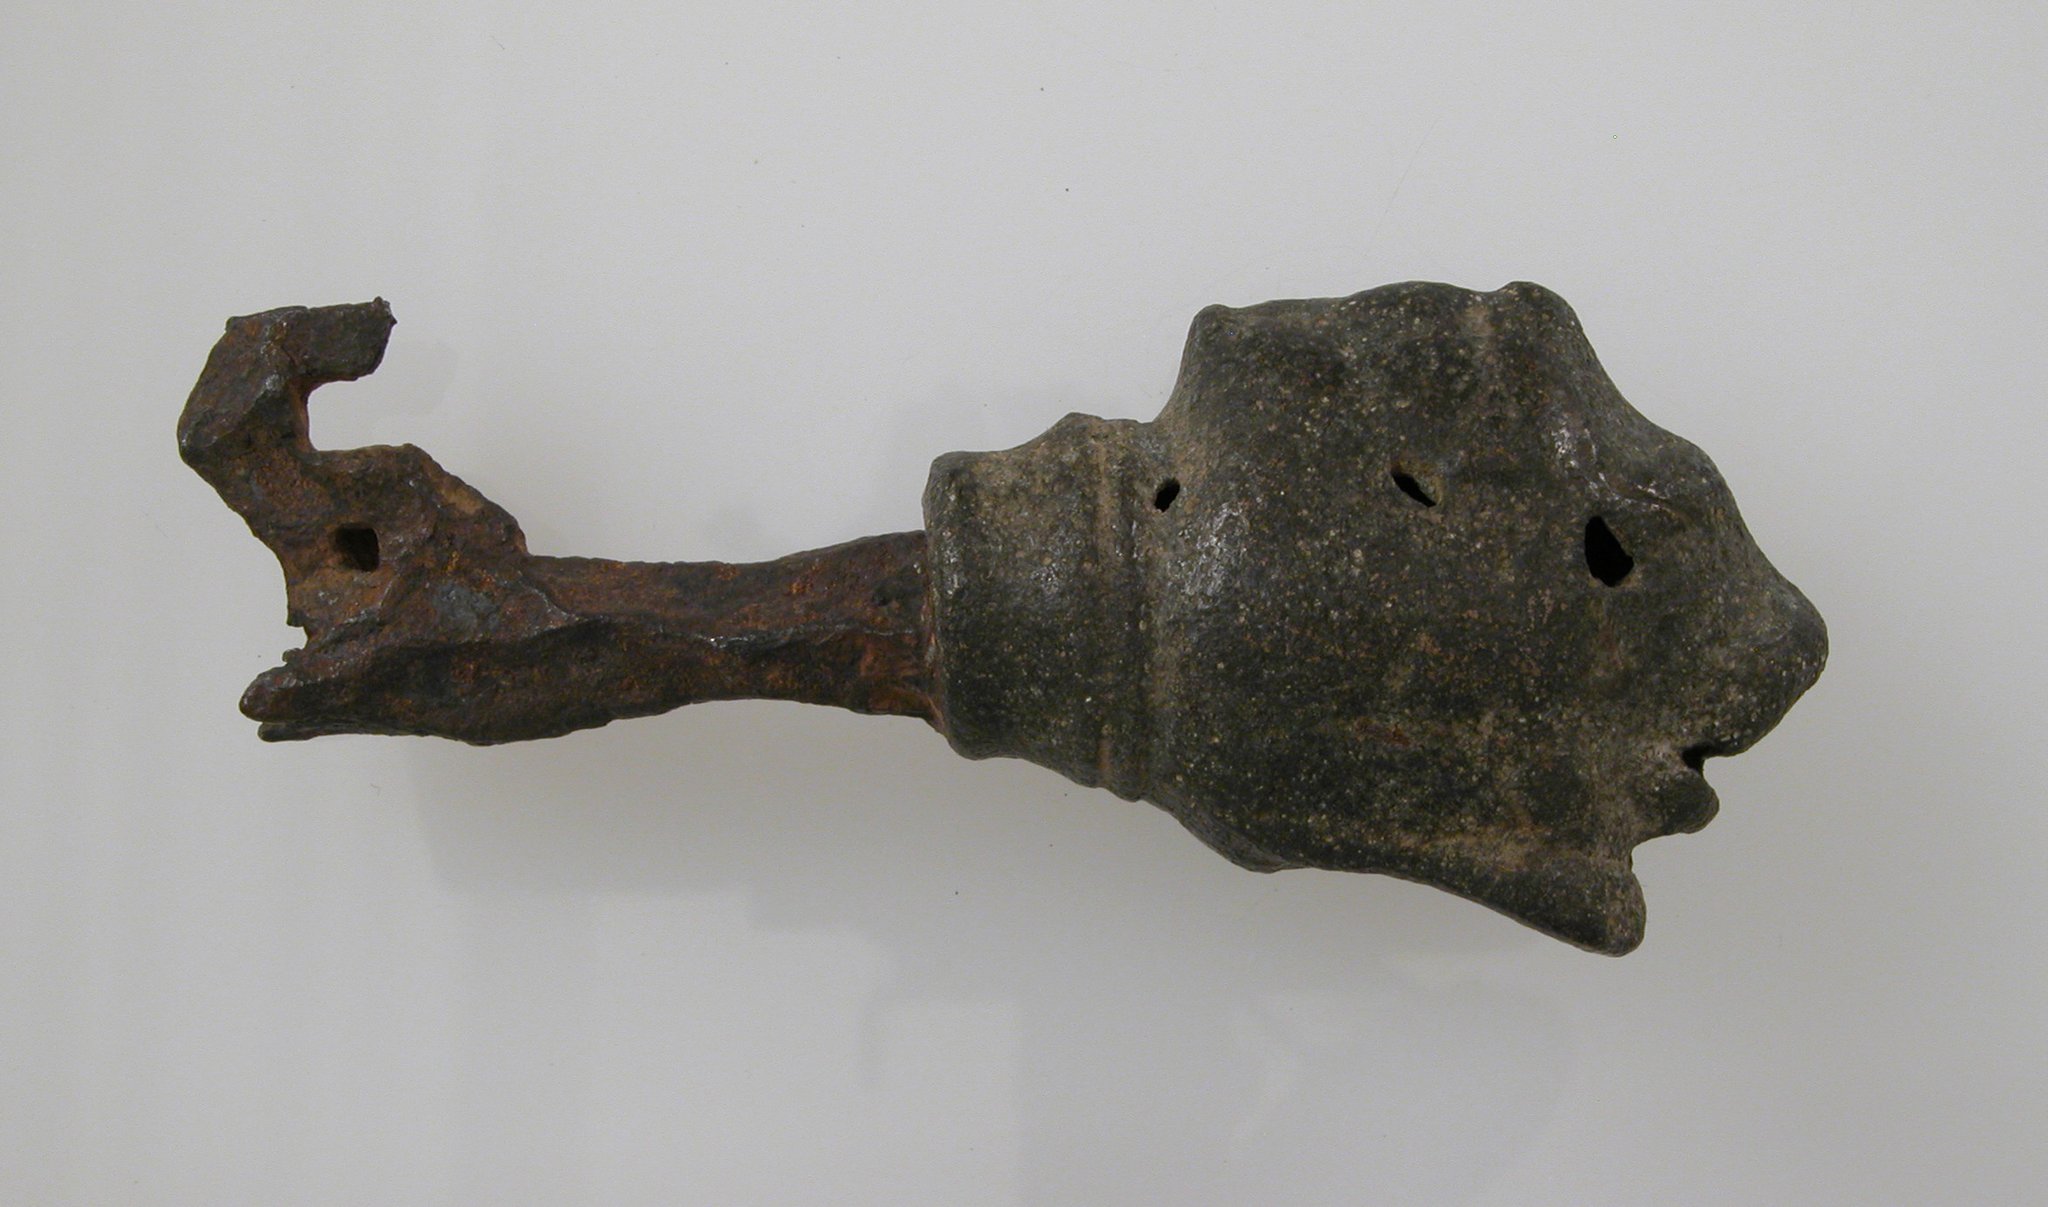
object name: key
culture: roman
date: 1-700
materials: copper alloy, iron